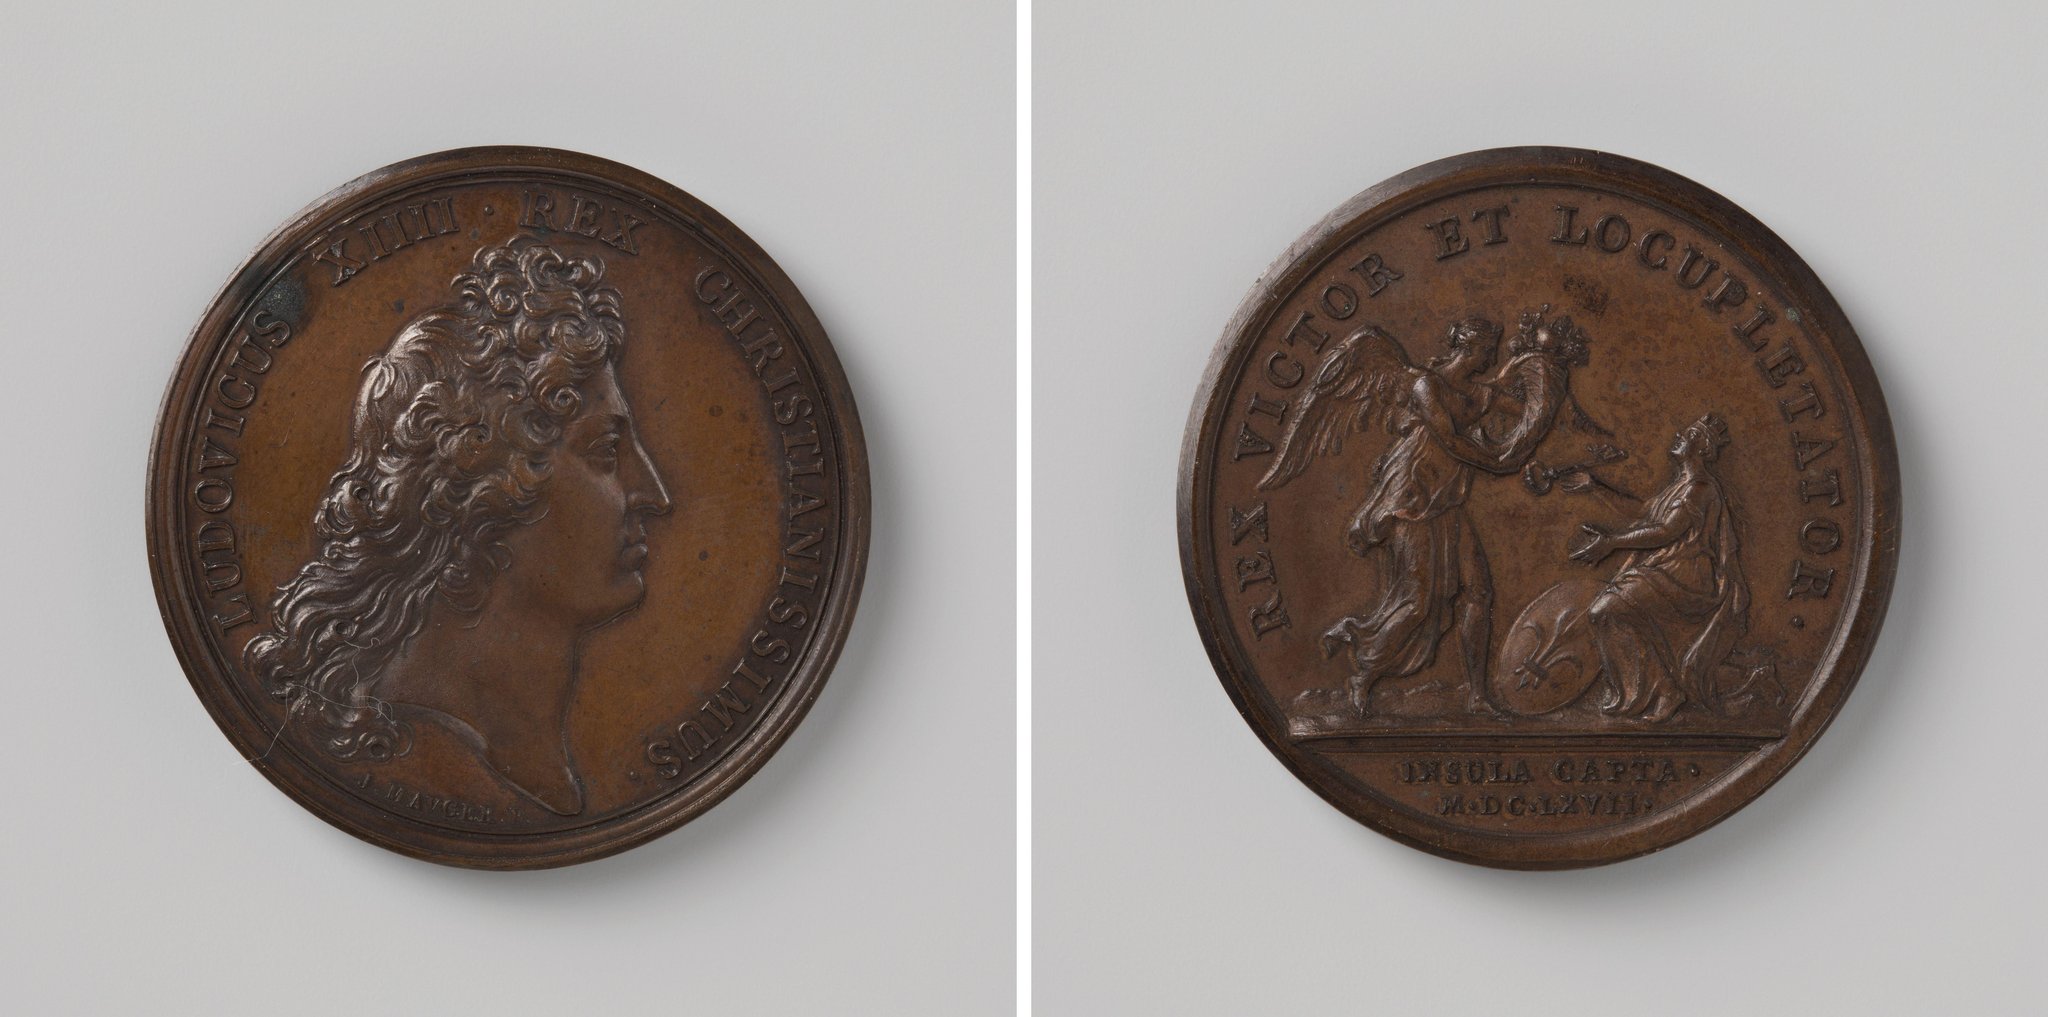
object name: history medal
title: Rijssel ingenomen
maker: jean mauger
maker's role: medailleur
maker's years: 1648-1722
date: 1699-1703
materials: bronze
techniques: striking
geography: paris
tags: lodewijk xiv (koning van frankrijk), lille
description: Bronzen penning. Voorzijde: borststuk jongeman (Lodewijk XIV) binnen omschrift. Keerzijde: gevleugelde Overwinning biedt aan zittende Rijssel hoorn van overvloed aan in ruil voor stadssleutels binnen omschrift